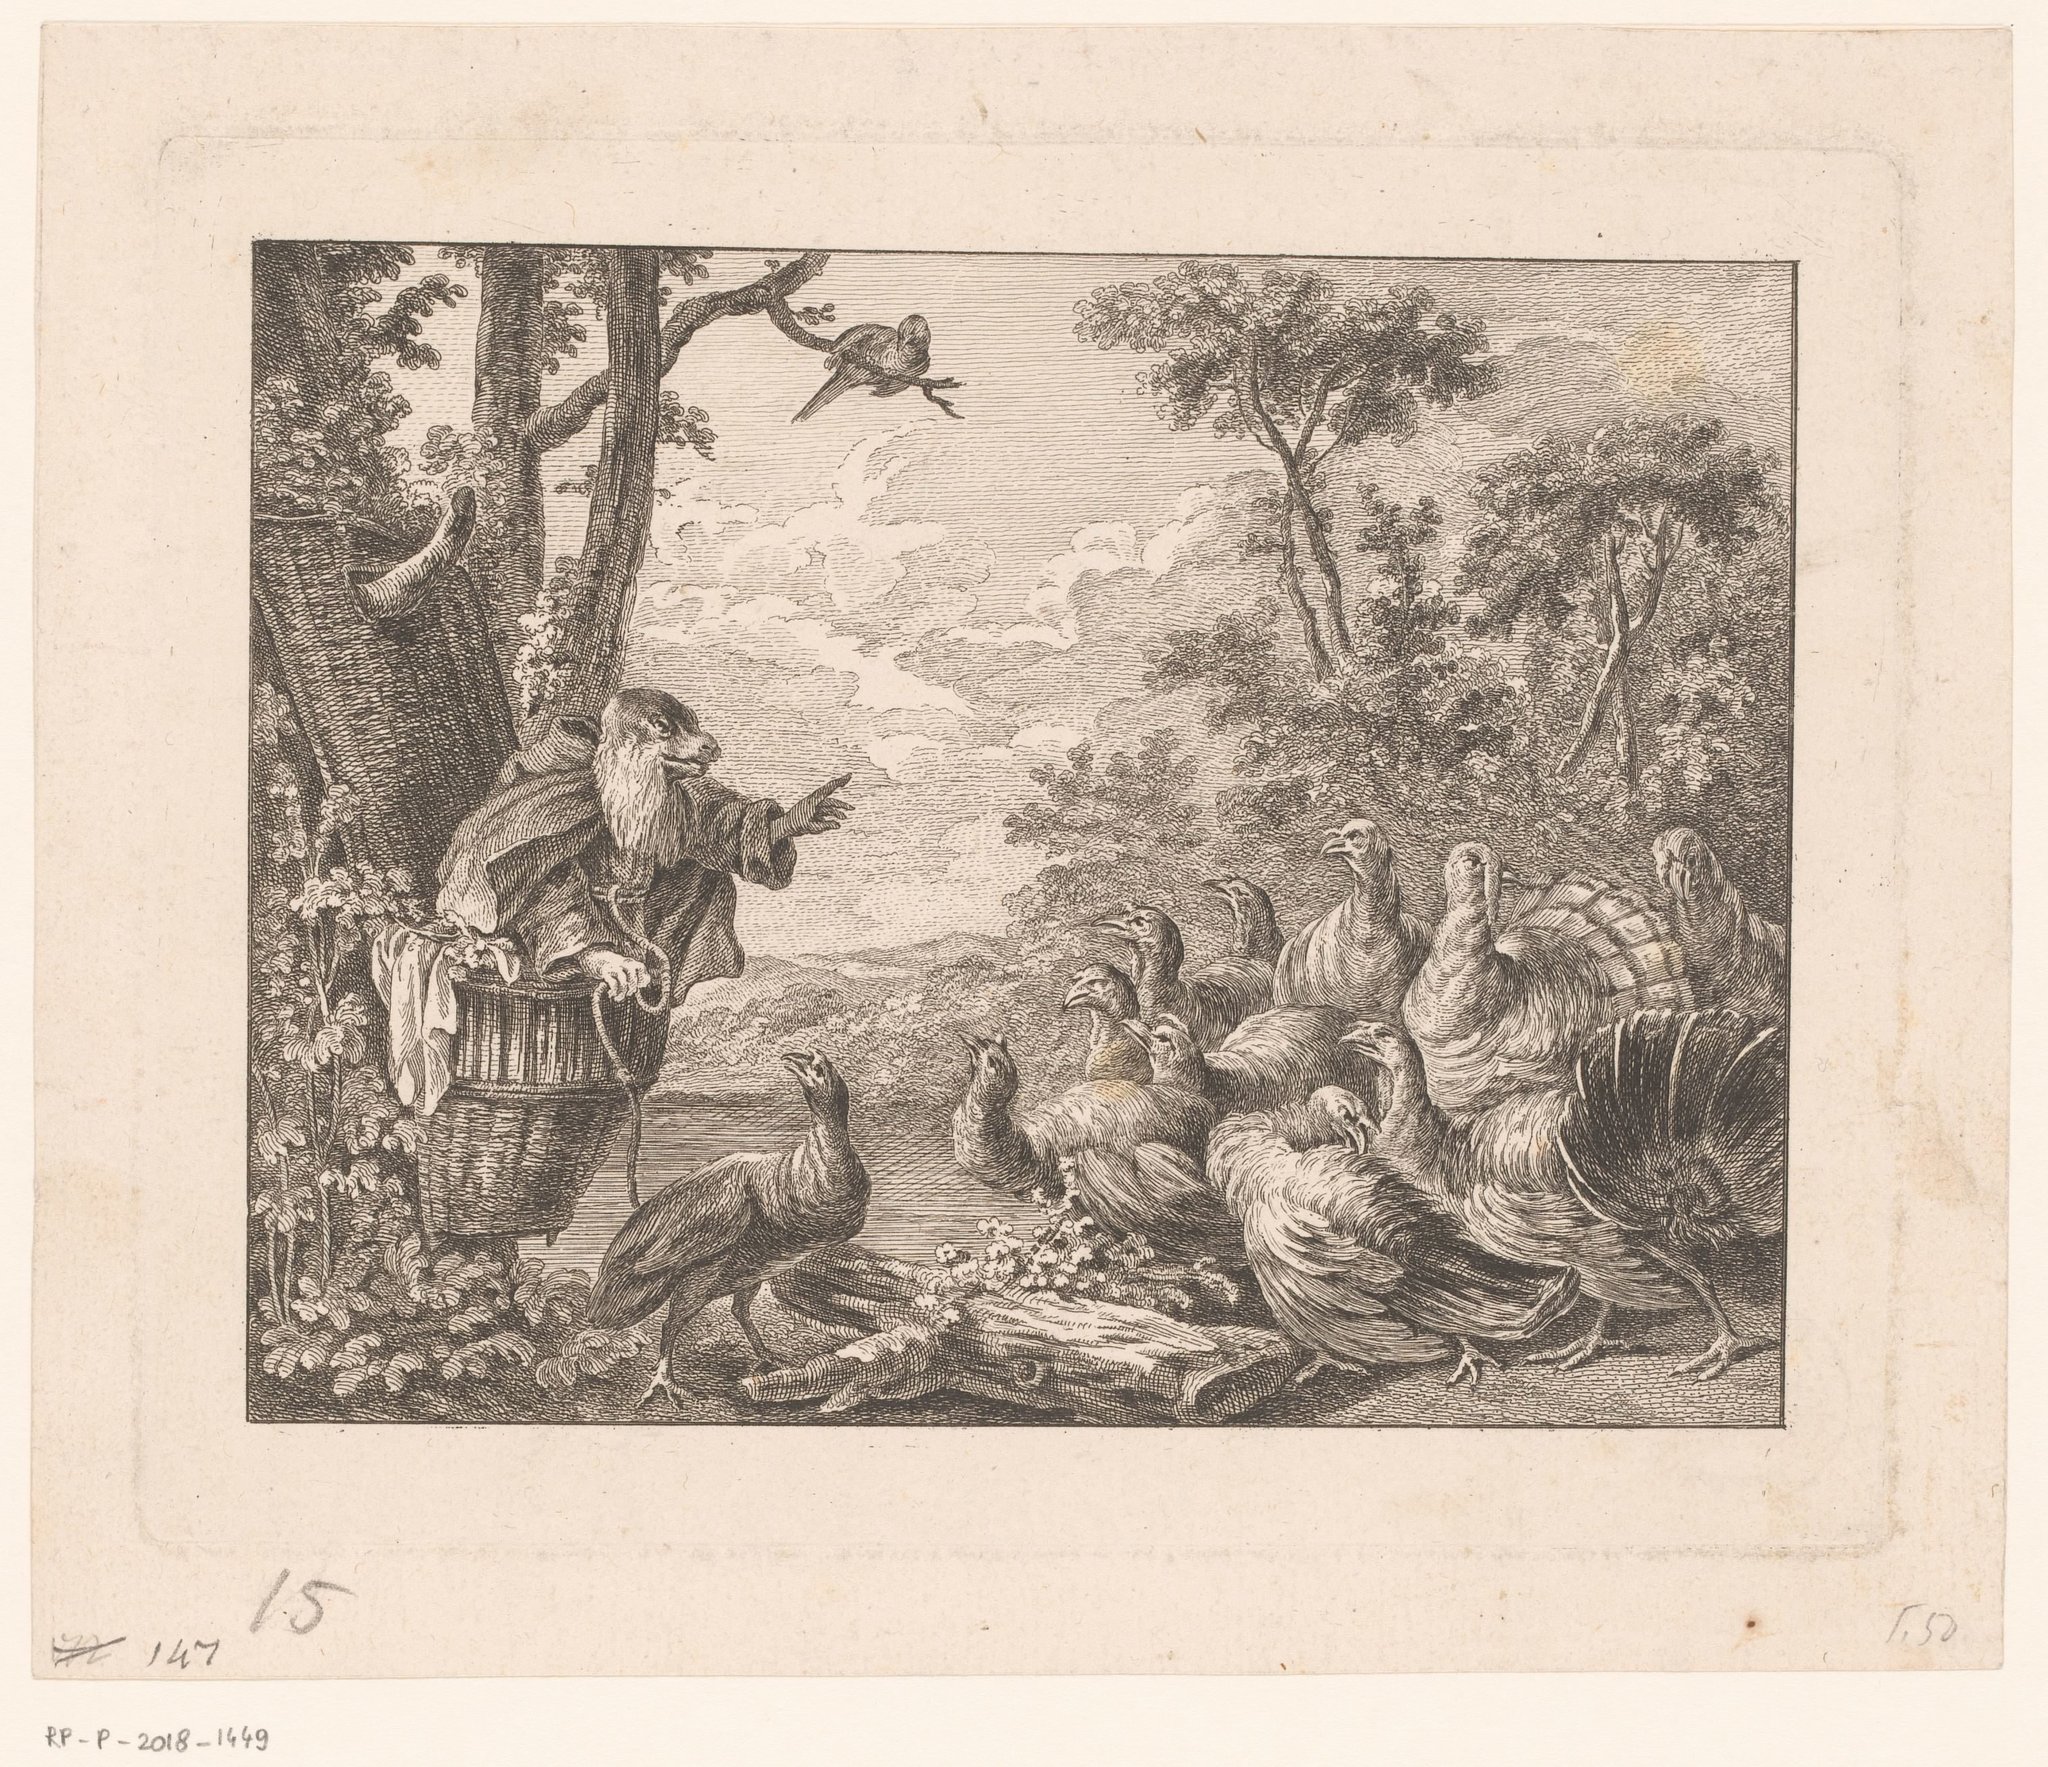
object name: print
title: Aapachtige spreekt groep kalkoenen toe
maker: claude gillot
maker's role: draughtsman, print maker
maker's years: 1673-1722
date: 1683-1722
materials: paper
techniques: engraving, etching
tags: animals acting as human beings, walker and runner birds: turkey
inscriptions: collector's mark: Lugt 240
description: Aapachtige in cape spreekt een groep kalkoenen toe vanuit een als spreekstoel opgehangen mand aan een boomtak.